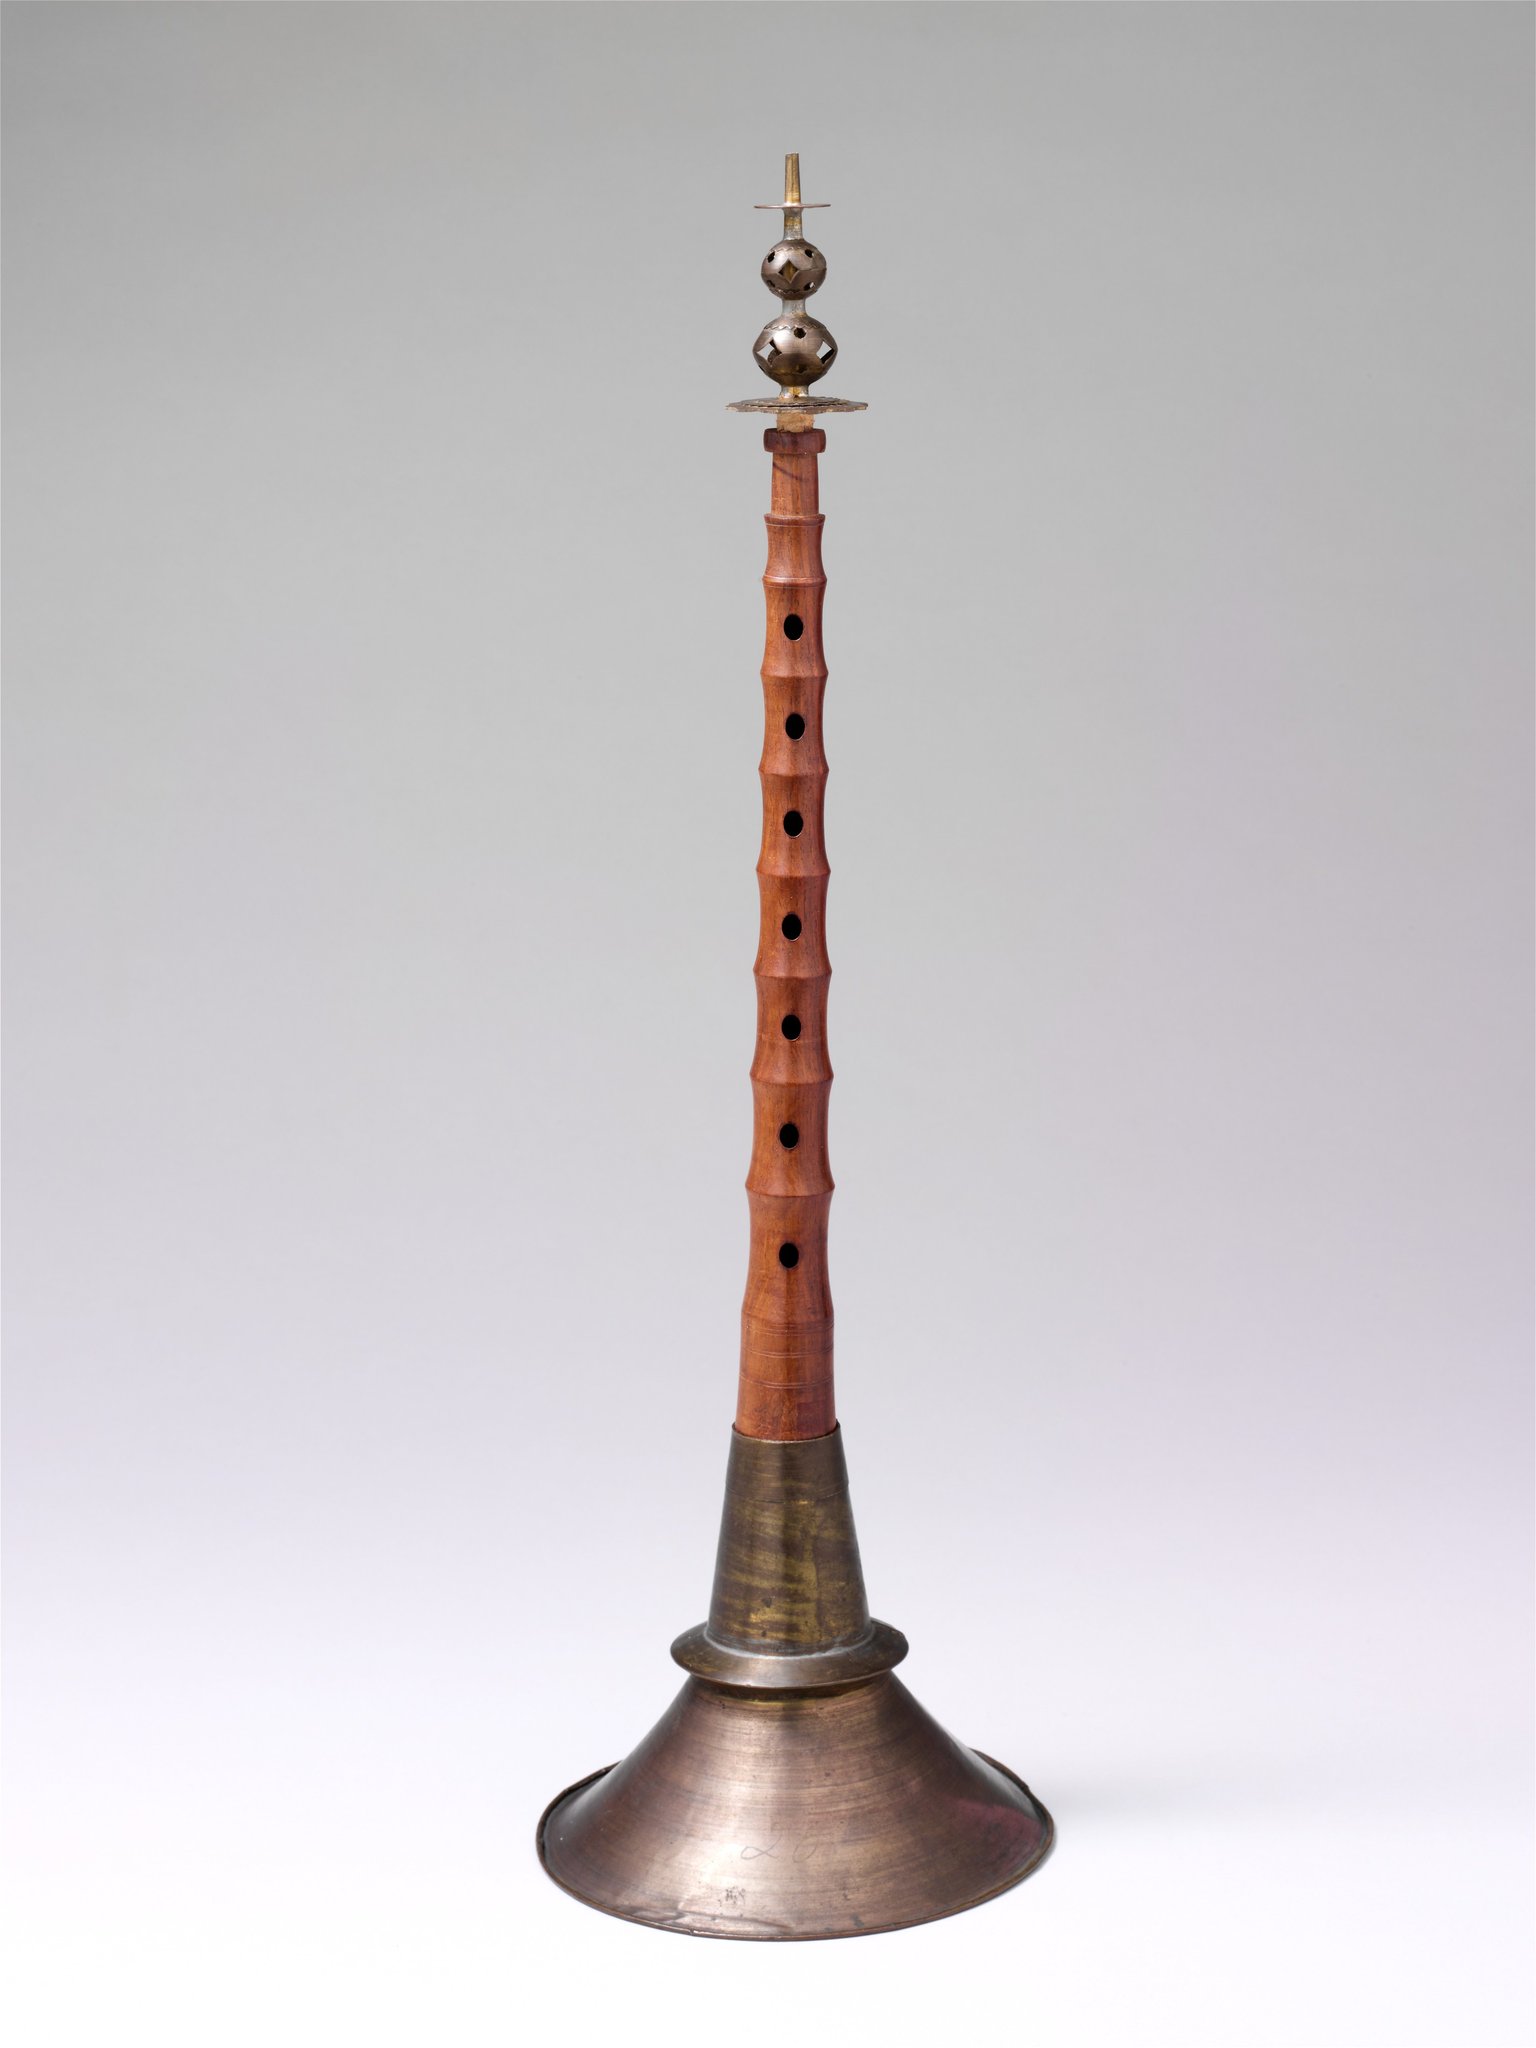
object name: suona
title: Suona (嗩吶 )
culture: chinese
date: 1801-1900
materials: brass, wood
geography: china